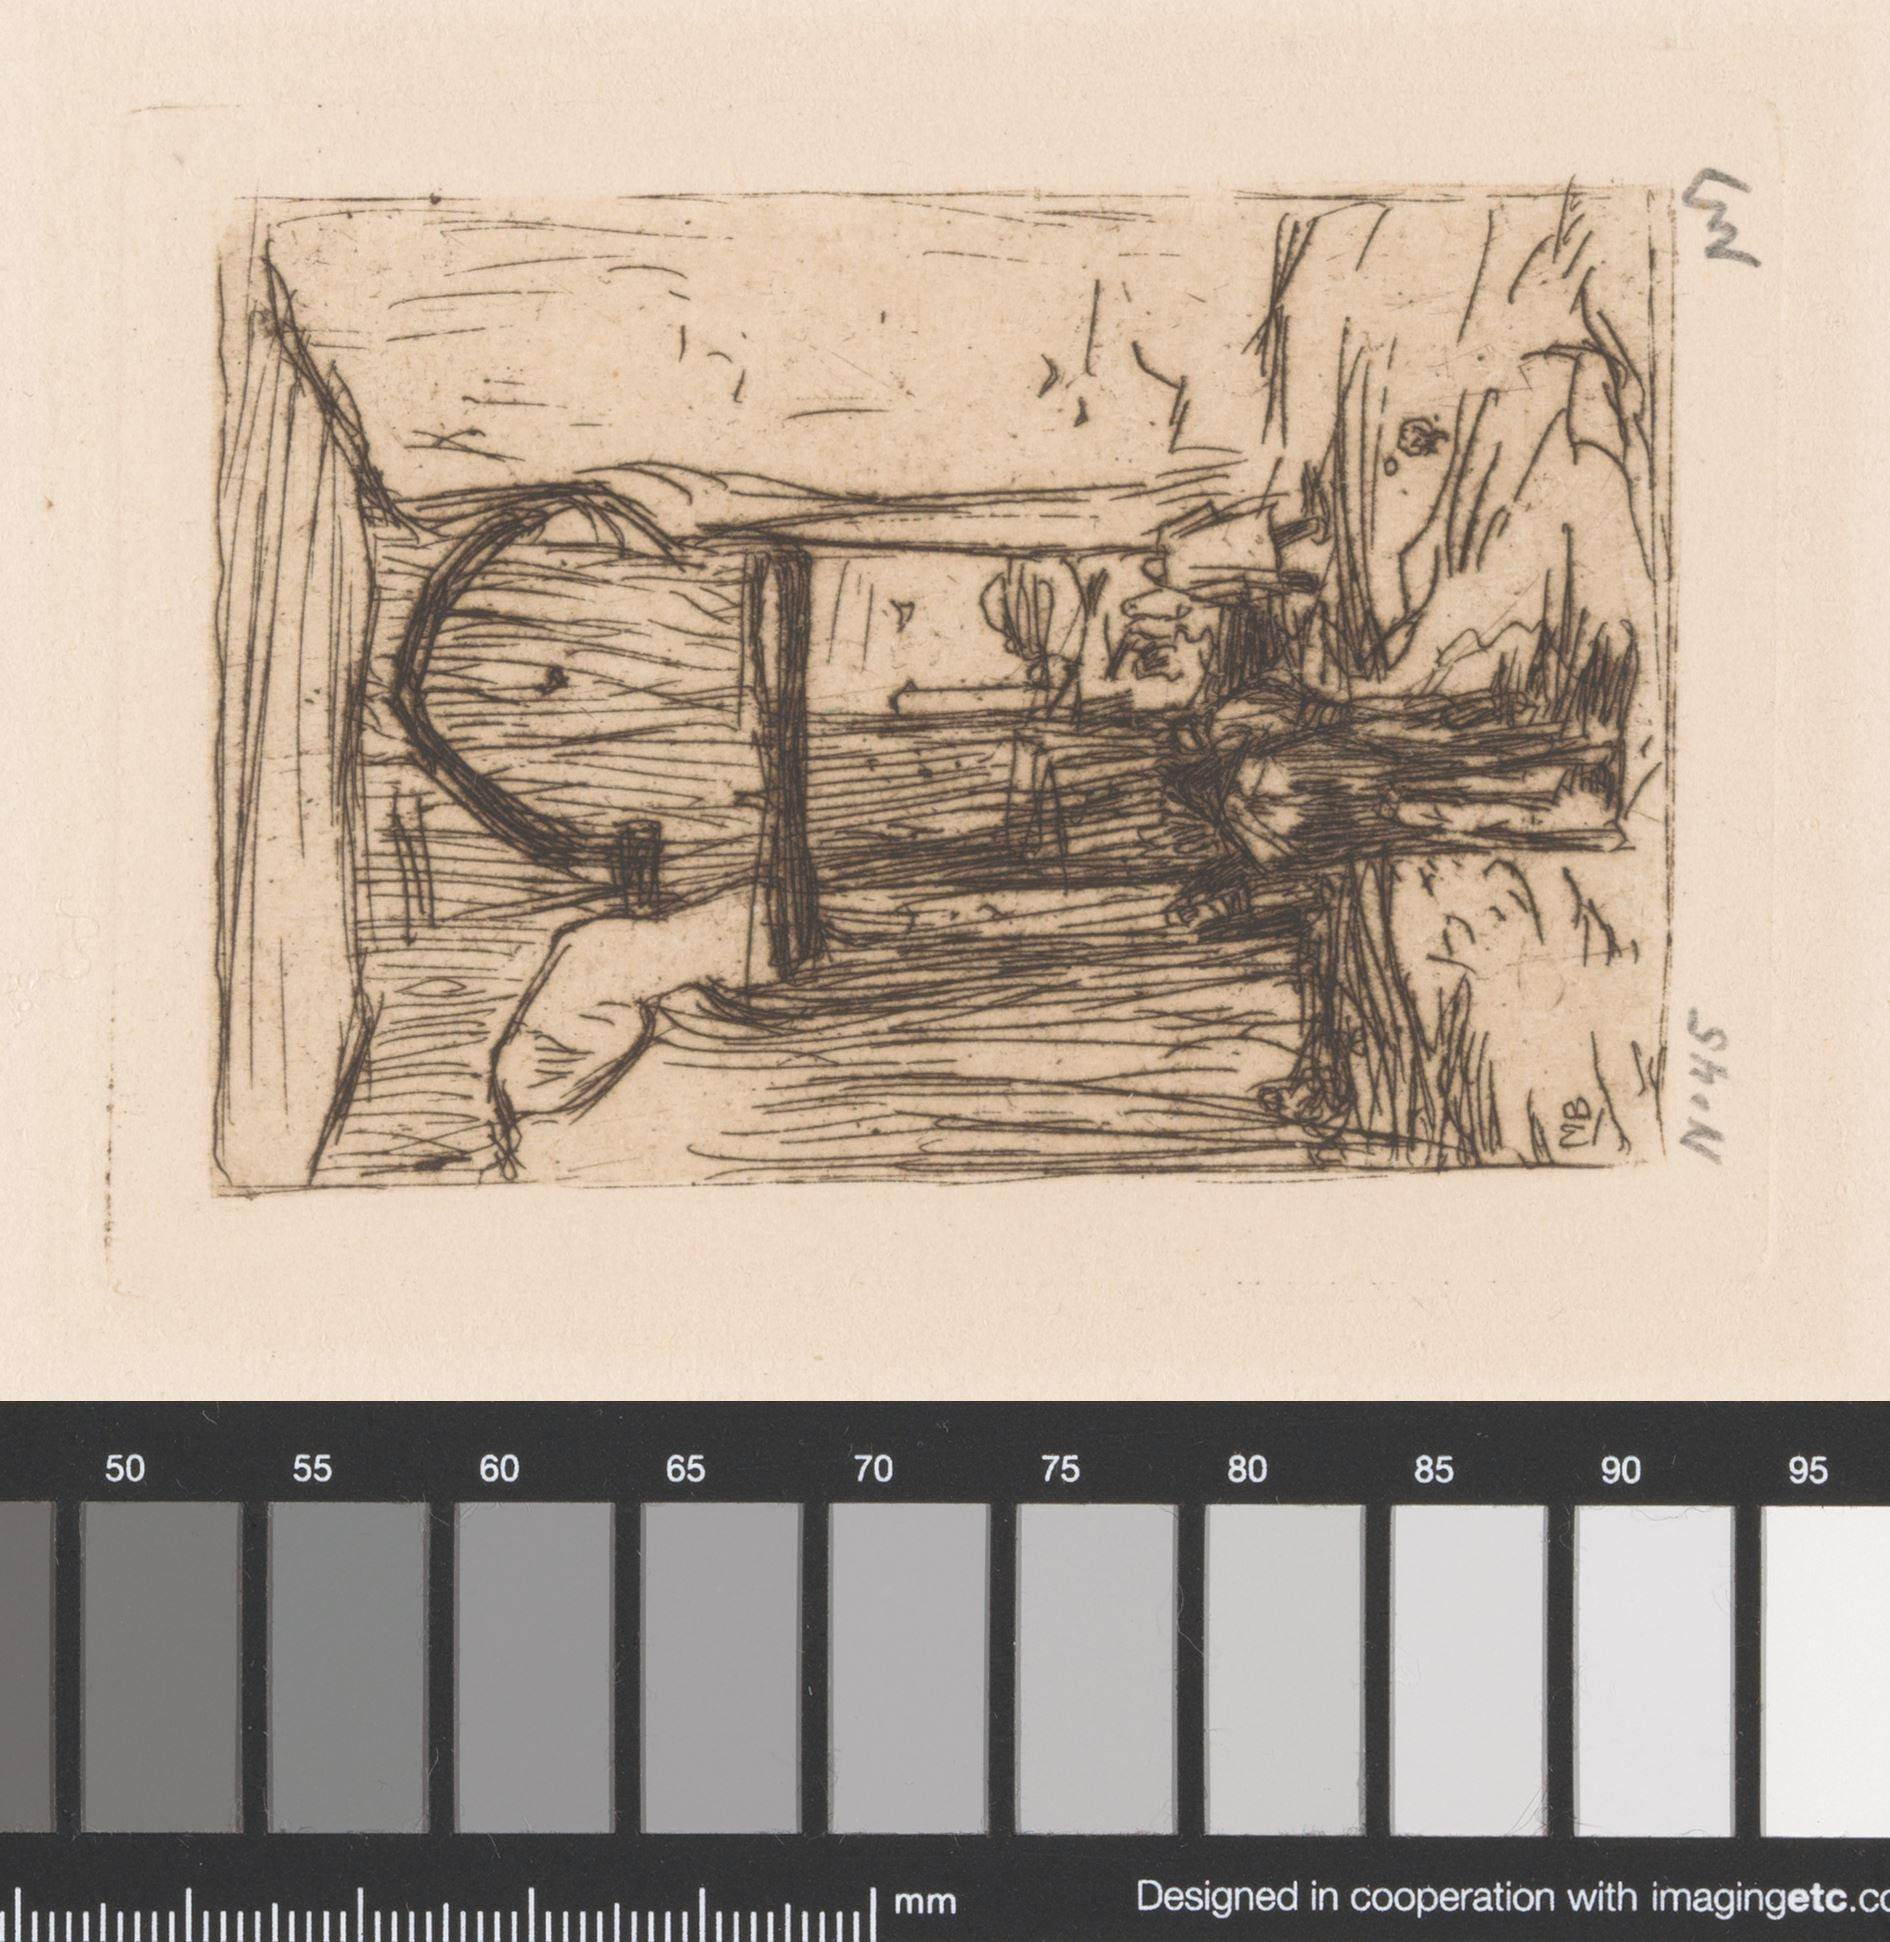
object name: print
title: Stadspoort in Adrianopel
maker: marius bauer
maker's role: draughtsman, print maker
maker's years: 1867-1932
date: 1889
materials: paper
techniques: etching, intaglio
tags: village-gate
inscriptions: collector's mark: Lugt 2760, collector's mark: Lugt 2228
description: Een lastdier voor een stadspoort in Adrianopel, de Griekse naam voor het huidige Edirne in Turkije.